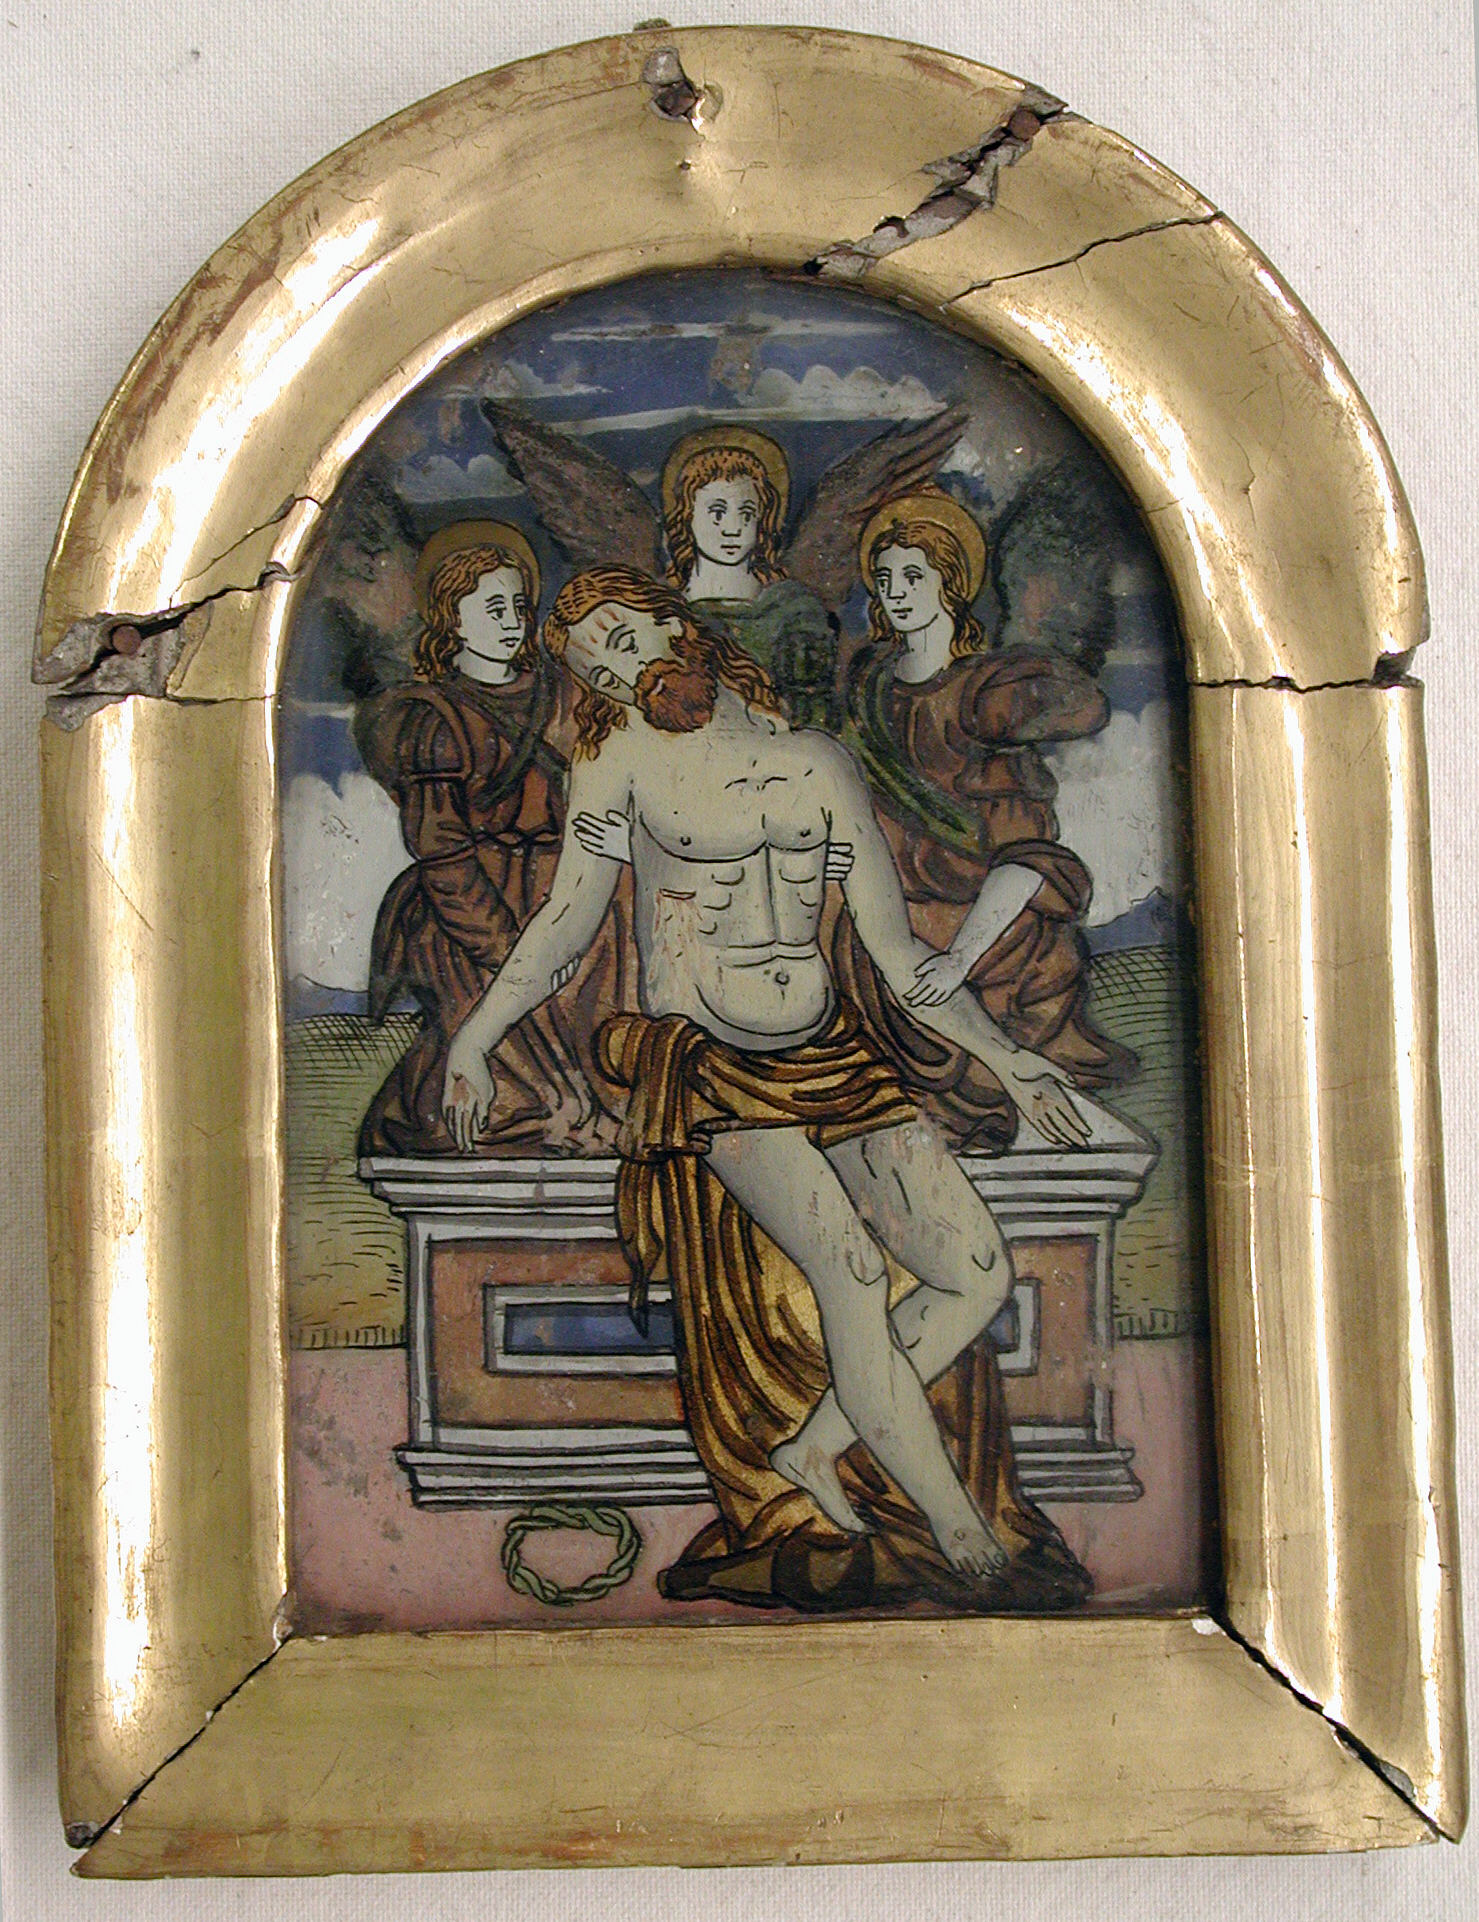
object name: panel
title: Christ in the Tomb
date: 1601-1700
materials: glass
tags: tombs,angels,christ